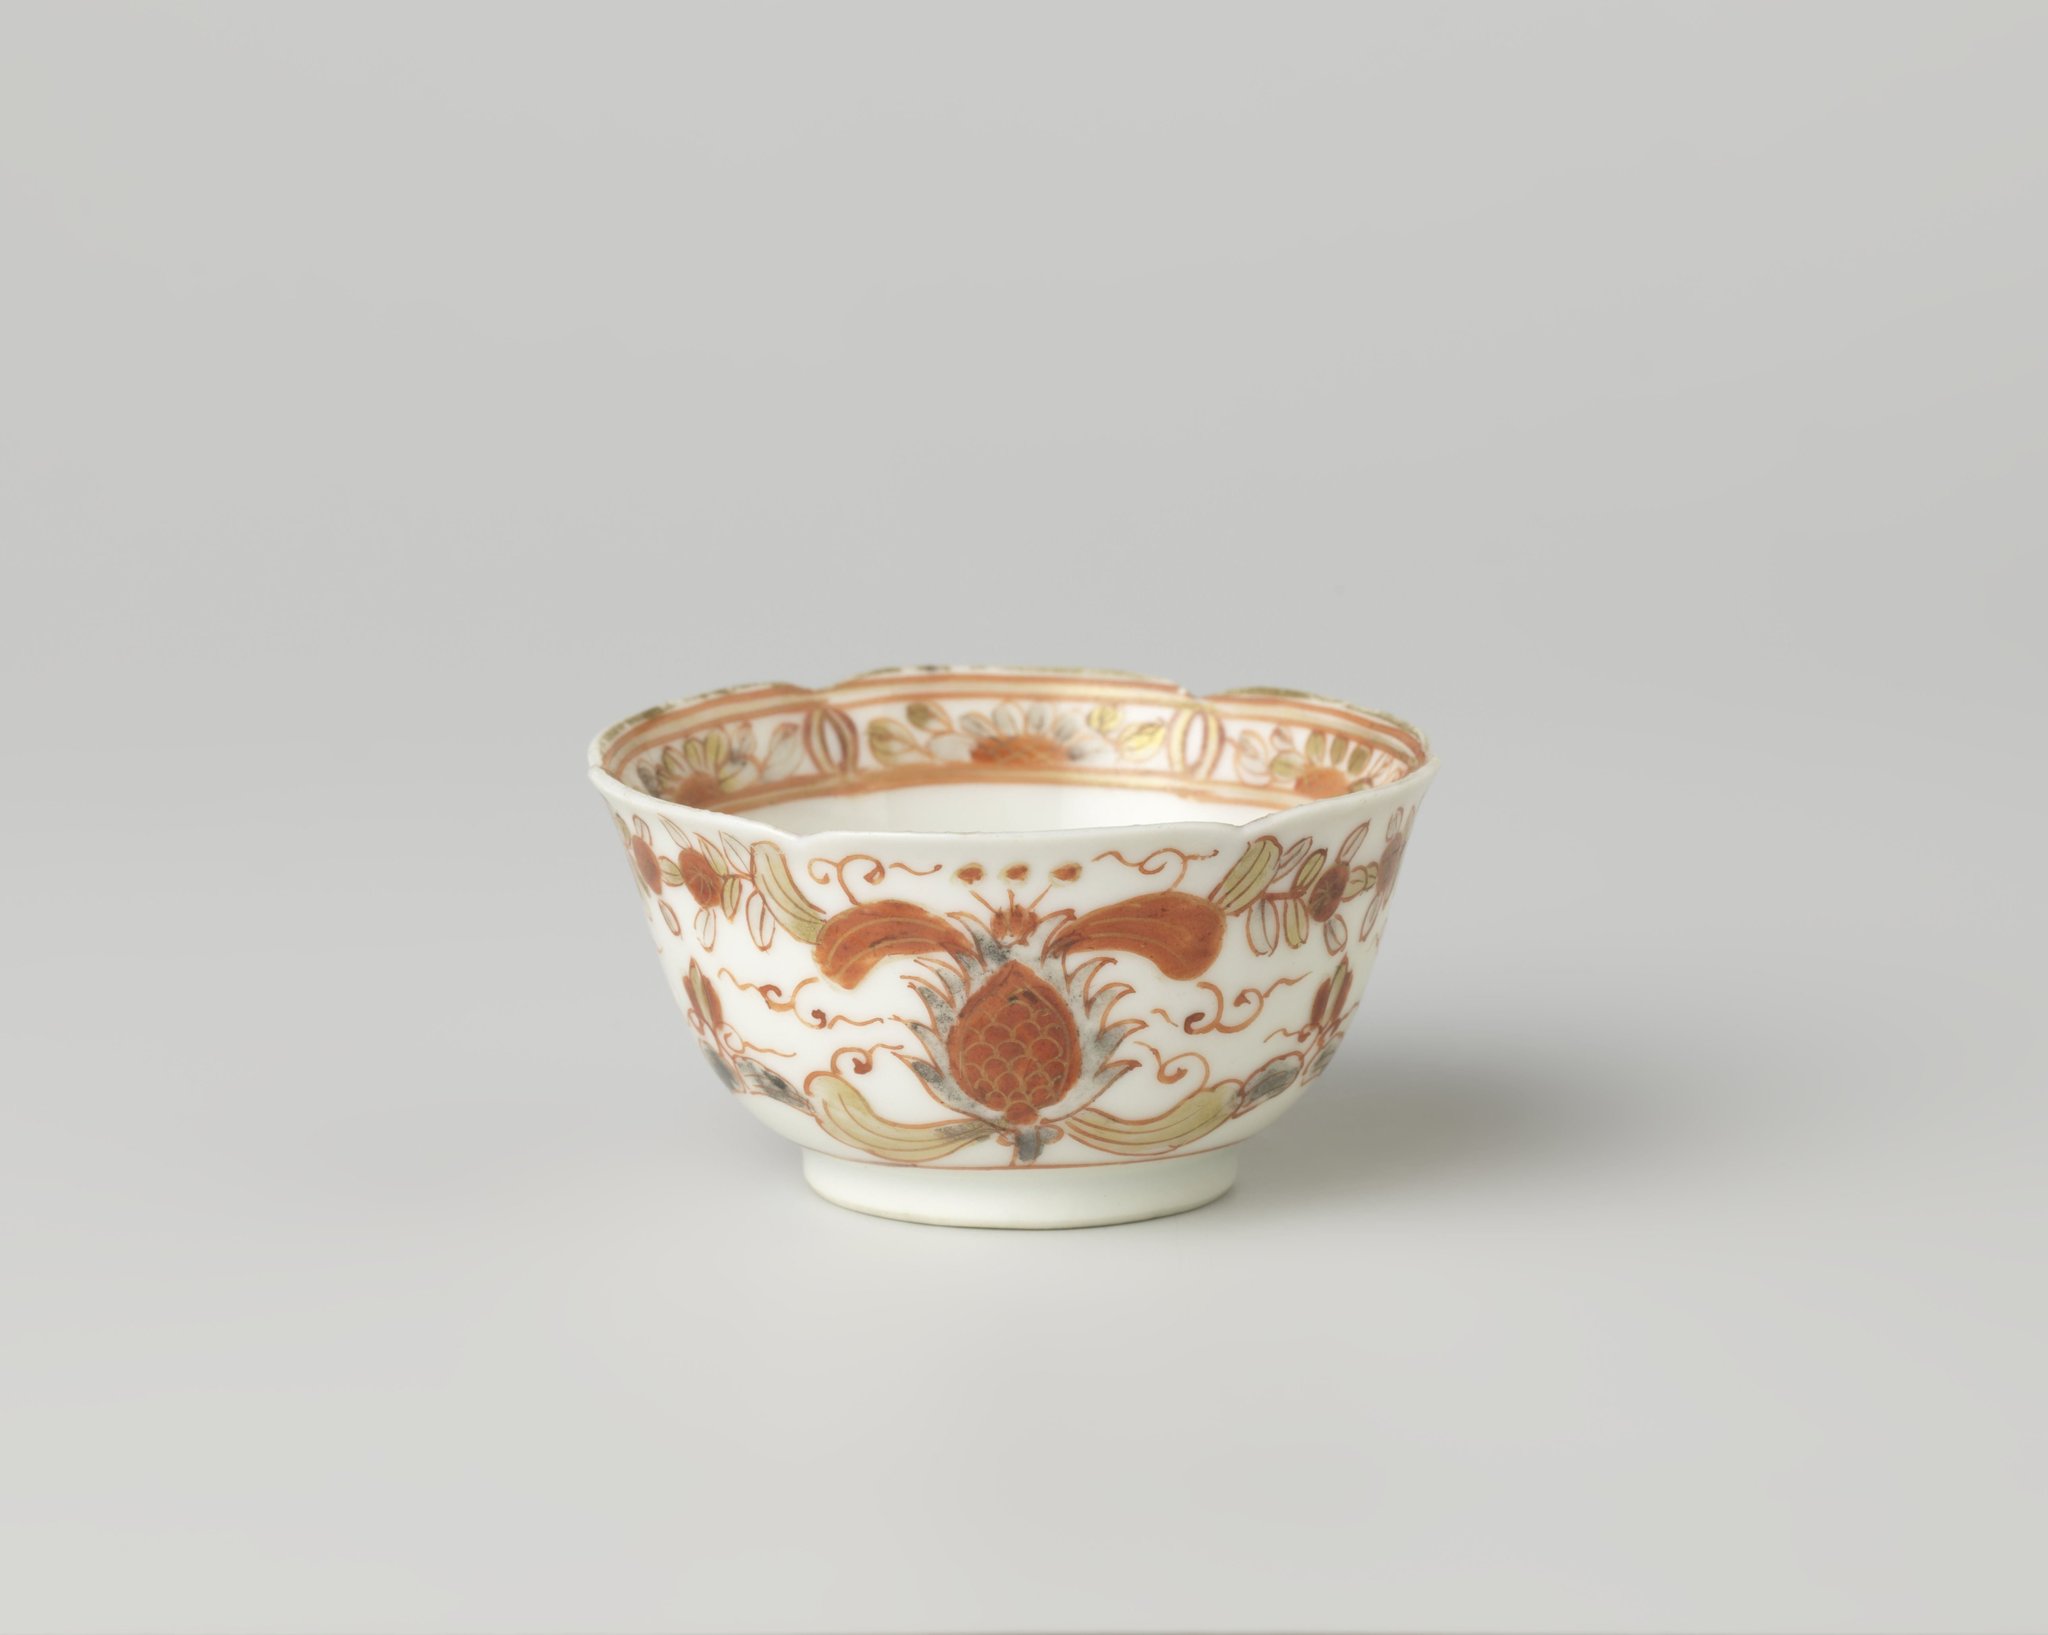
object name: kop en schotel, kop en schotel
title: Bell-shaped cup with scrolls and stylised flowers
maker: Anonymous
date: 1700-1724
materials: glaze, gold, paint, porcelain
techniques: firing, gilding, turning, vitrification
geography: china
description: Kop en schotel, versierd met palmetten in rood goud en zwart. Melk en bloed.